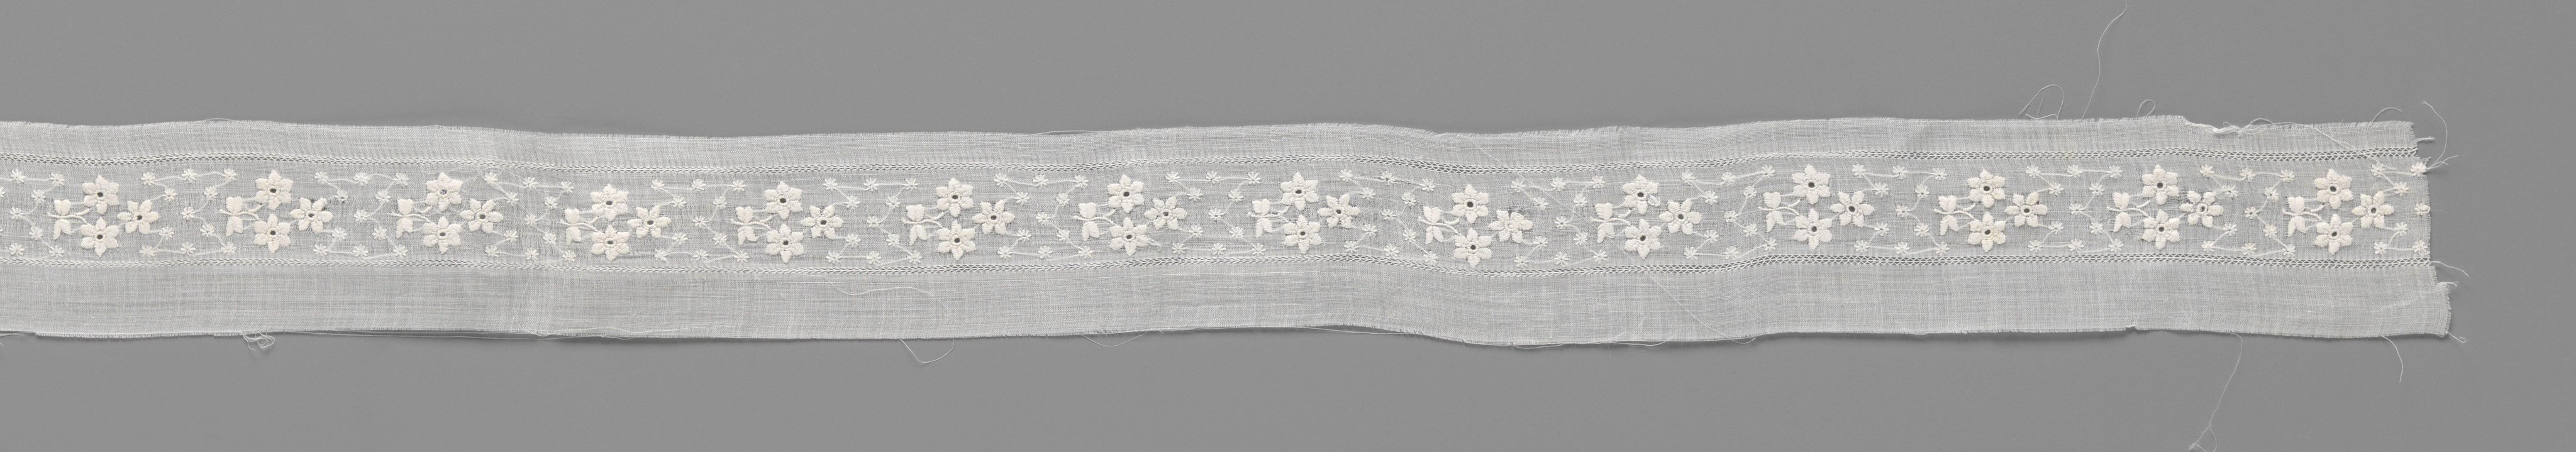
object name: strip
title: Tussenzetsel van batist met witwerk van vergeet-mij-nieten en sterren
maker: Anonymous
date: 1850-1860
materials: textile, linen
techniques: satin stitch, weave, embroidery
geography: netherlands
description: Tussenzetsel van naturelkleurig batist met witwerk. Binnen opengewerkte lijsten staat een lopend patroon van vergeet-mij-nieten met stelen in de lengterichting, waaraan drie vergeet-mij-nieten. Tussen elke tak staan elf sterren. De lange zijden zijn niet afgewerkt.